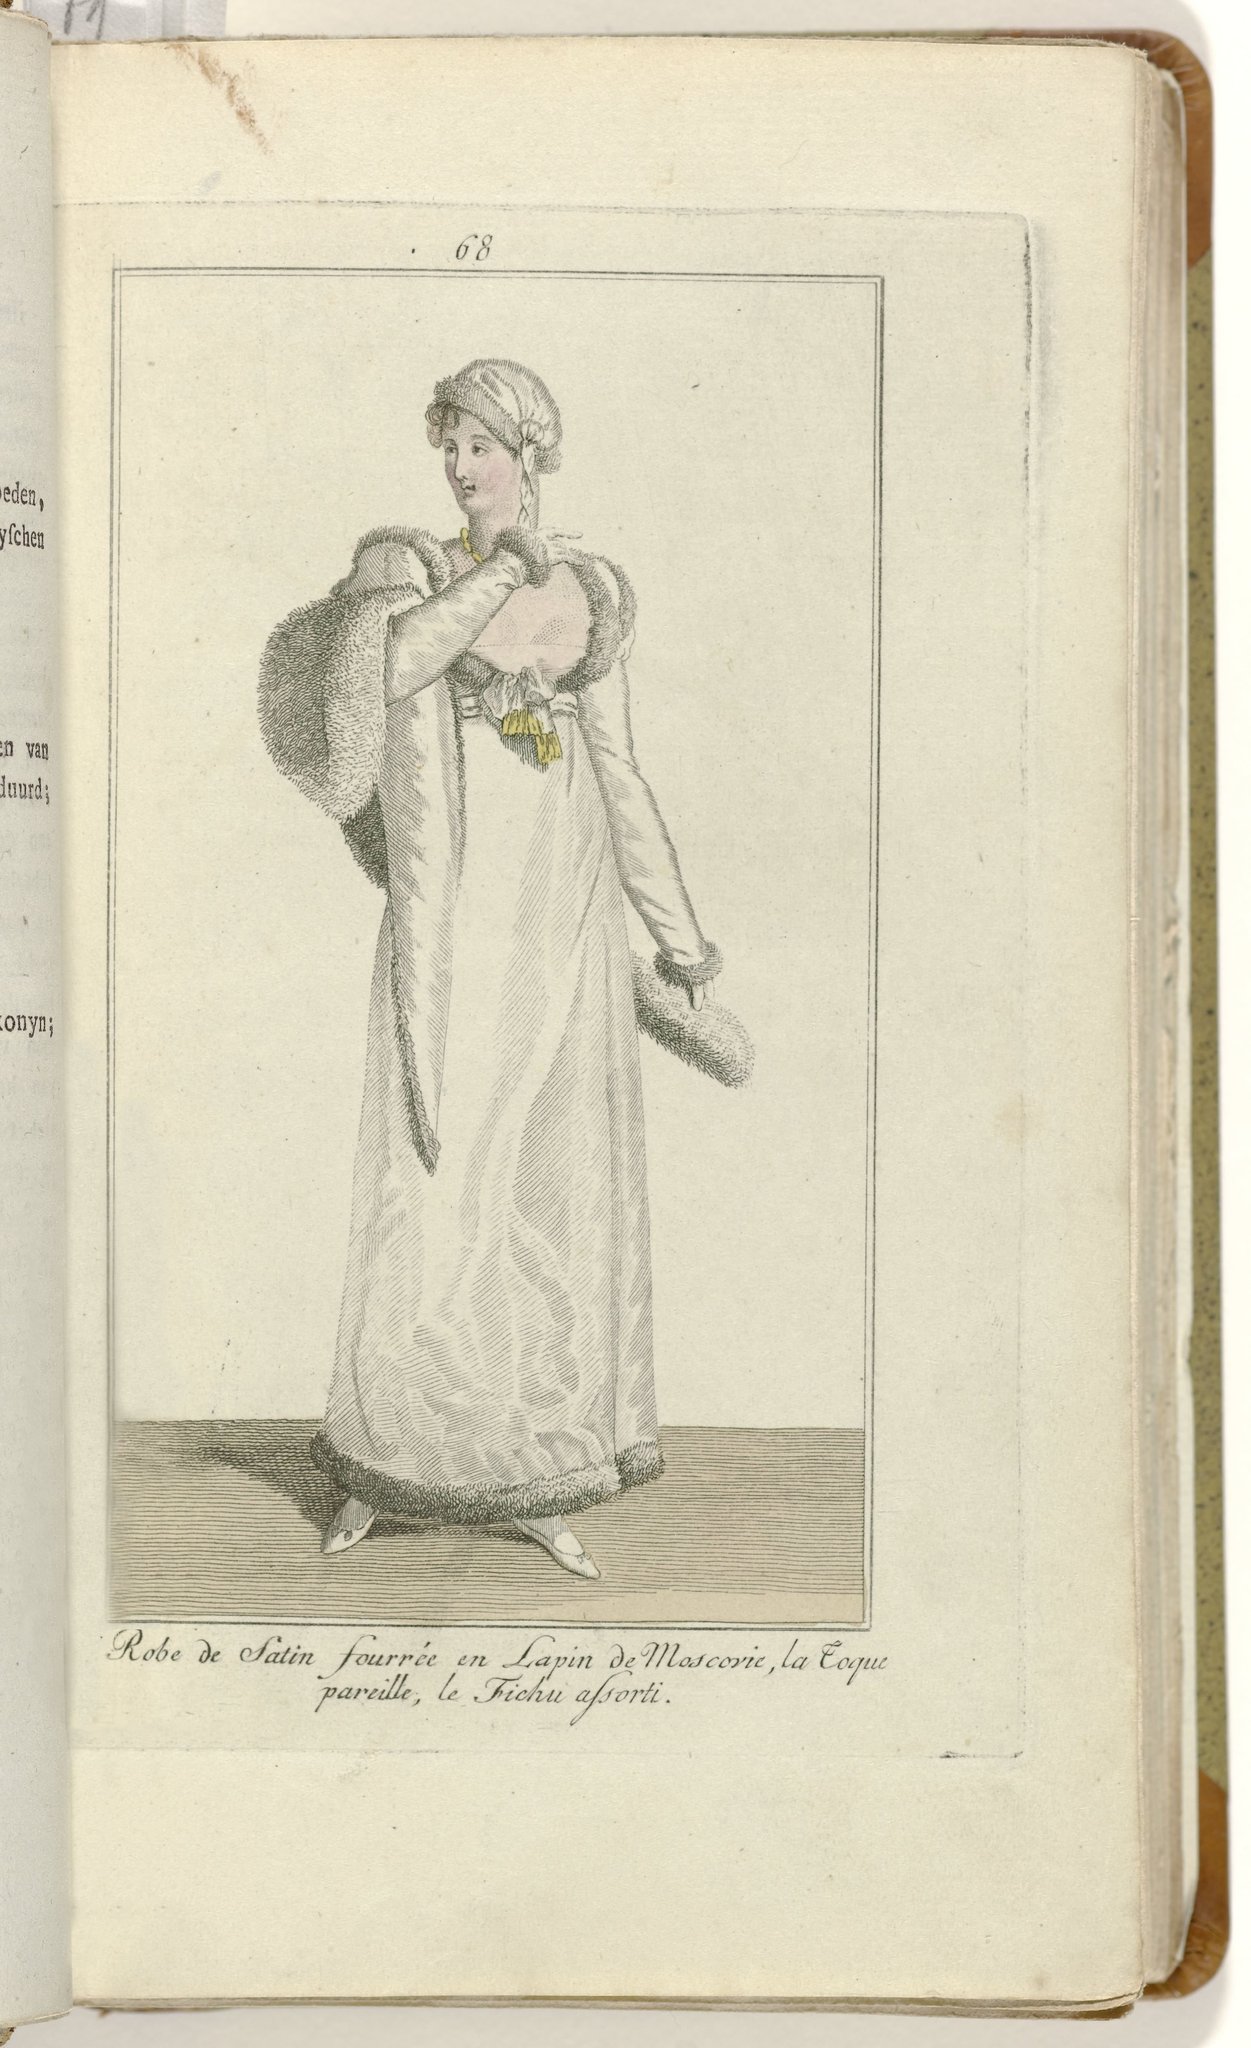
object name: magazine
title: Elegantia, of tijdschrift van mode, luxe en smaak voor dames, Januari 1809, No. 68: Robe de Satin...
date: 1809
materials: paper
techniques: engraving, hand coloring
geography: amsterdam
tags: head-gear: toque (+ women's clothes), border, ribbon, braid (+ fur used for clothes), piece of clothing covering the breast or décolleté (fichu) (+ fur used for clothes), fashion plates, dress, gown (+ women's clothes), piece of clothing covering the breast or décolleté (fichu) (+ women's clothes)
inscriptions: caption: ‘Robe de Satin fourrée en Lapin de Moscorie, la Toque pareille, Le Fichu assorti’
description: Volgens de begeleidende tekst (p. 32): Wit satijnen japon met bont van 'Moskovisch konijn'. Toque en fichu van hetzelfde. Prent uit het modetijdschrift Elegantia, of tijdschrift van mode, luxe en smaak voor dames 1807-1814 (onderbroken door de periode 1811-1813).